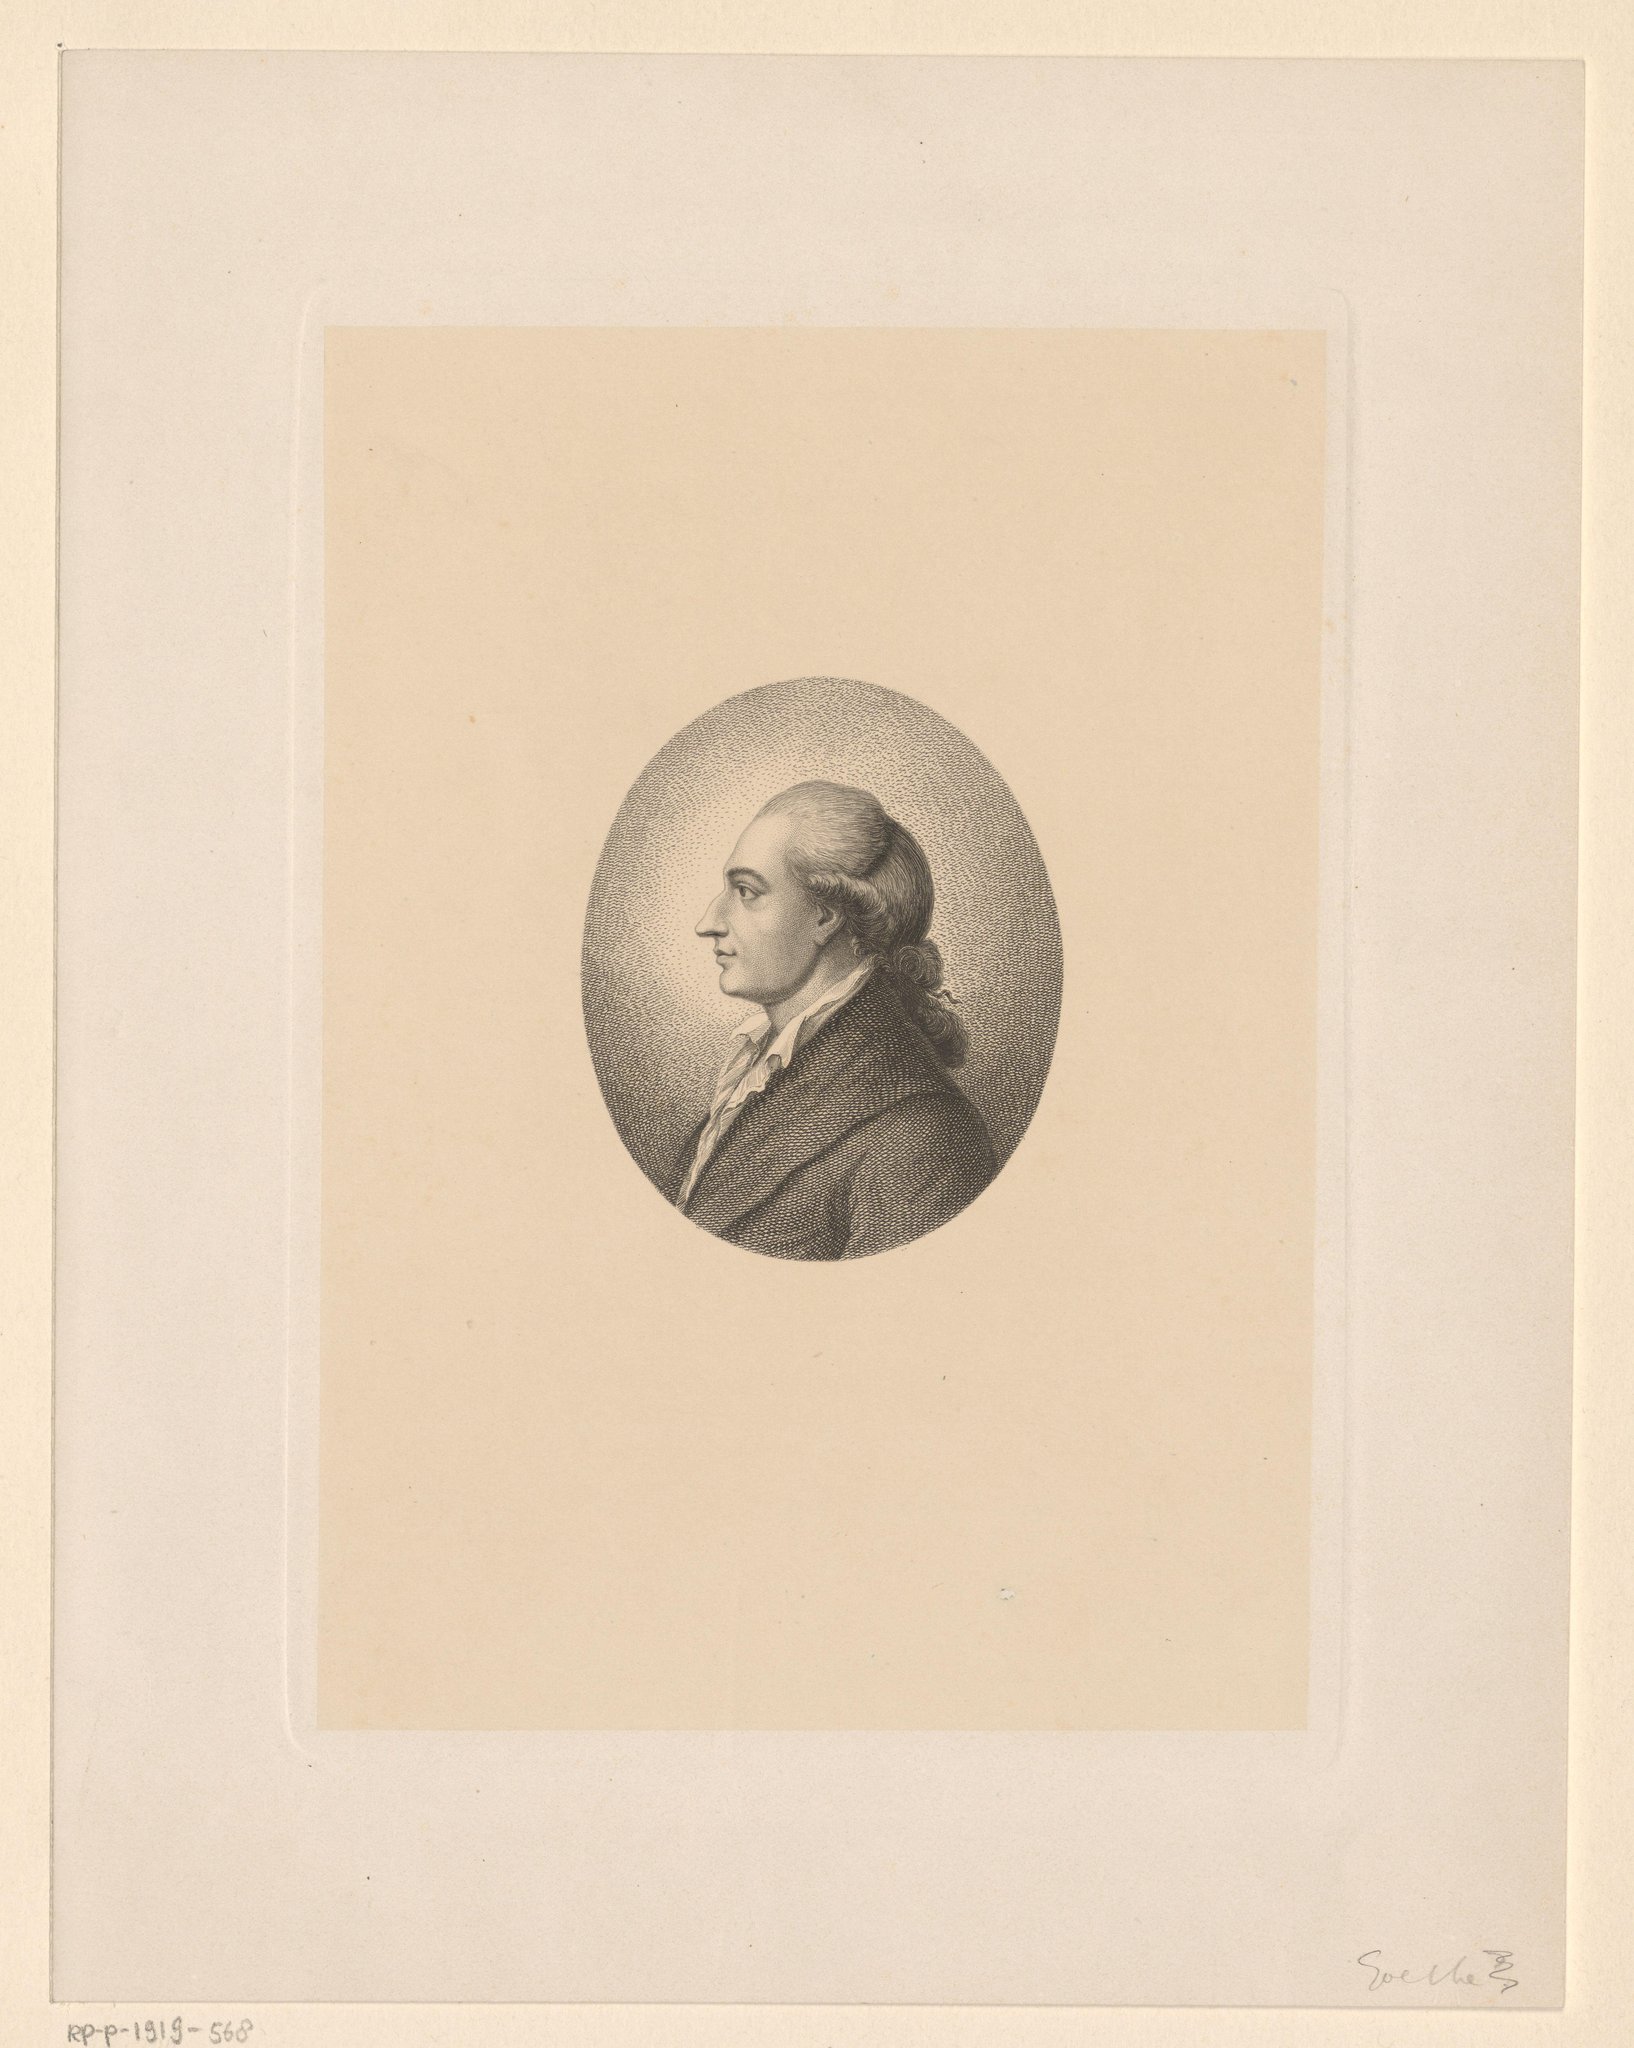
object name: print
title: Portret van Johann Wolfgang von Goethe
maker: Anonymous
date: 1774-1820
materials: paper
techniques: engraving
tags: draughtsman, johann wolfgang von goethe, historical persons, portrait of a writer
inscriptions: collector's mark: Lugt 2228